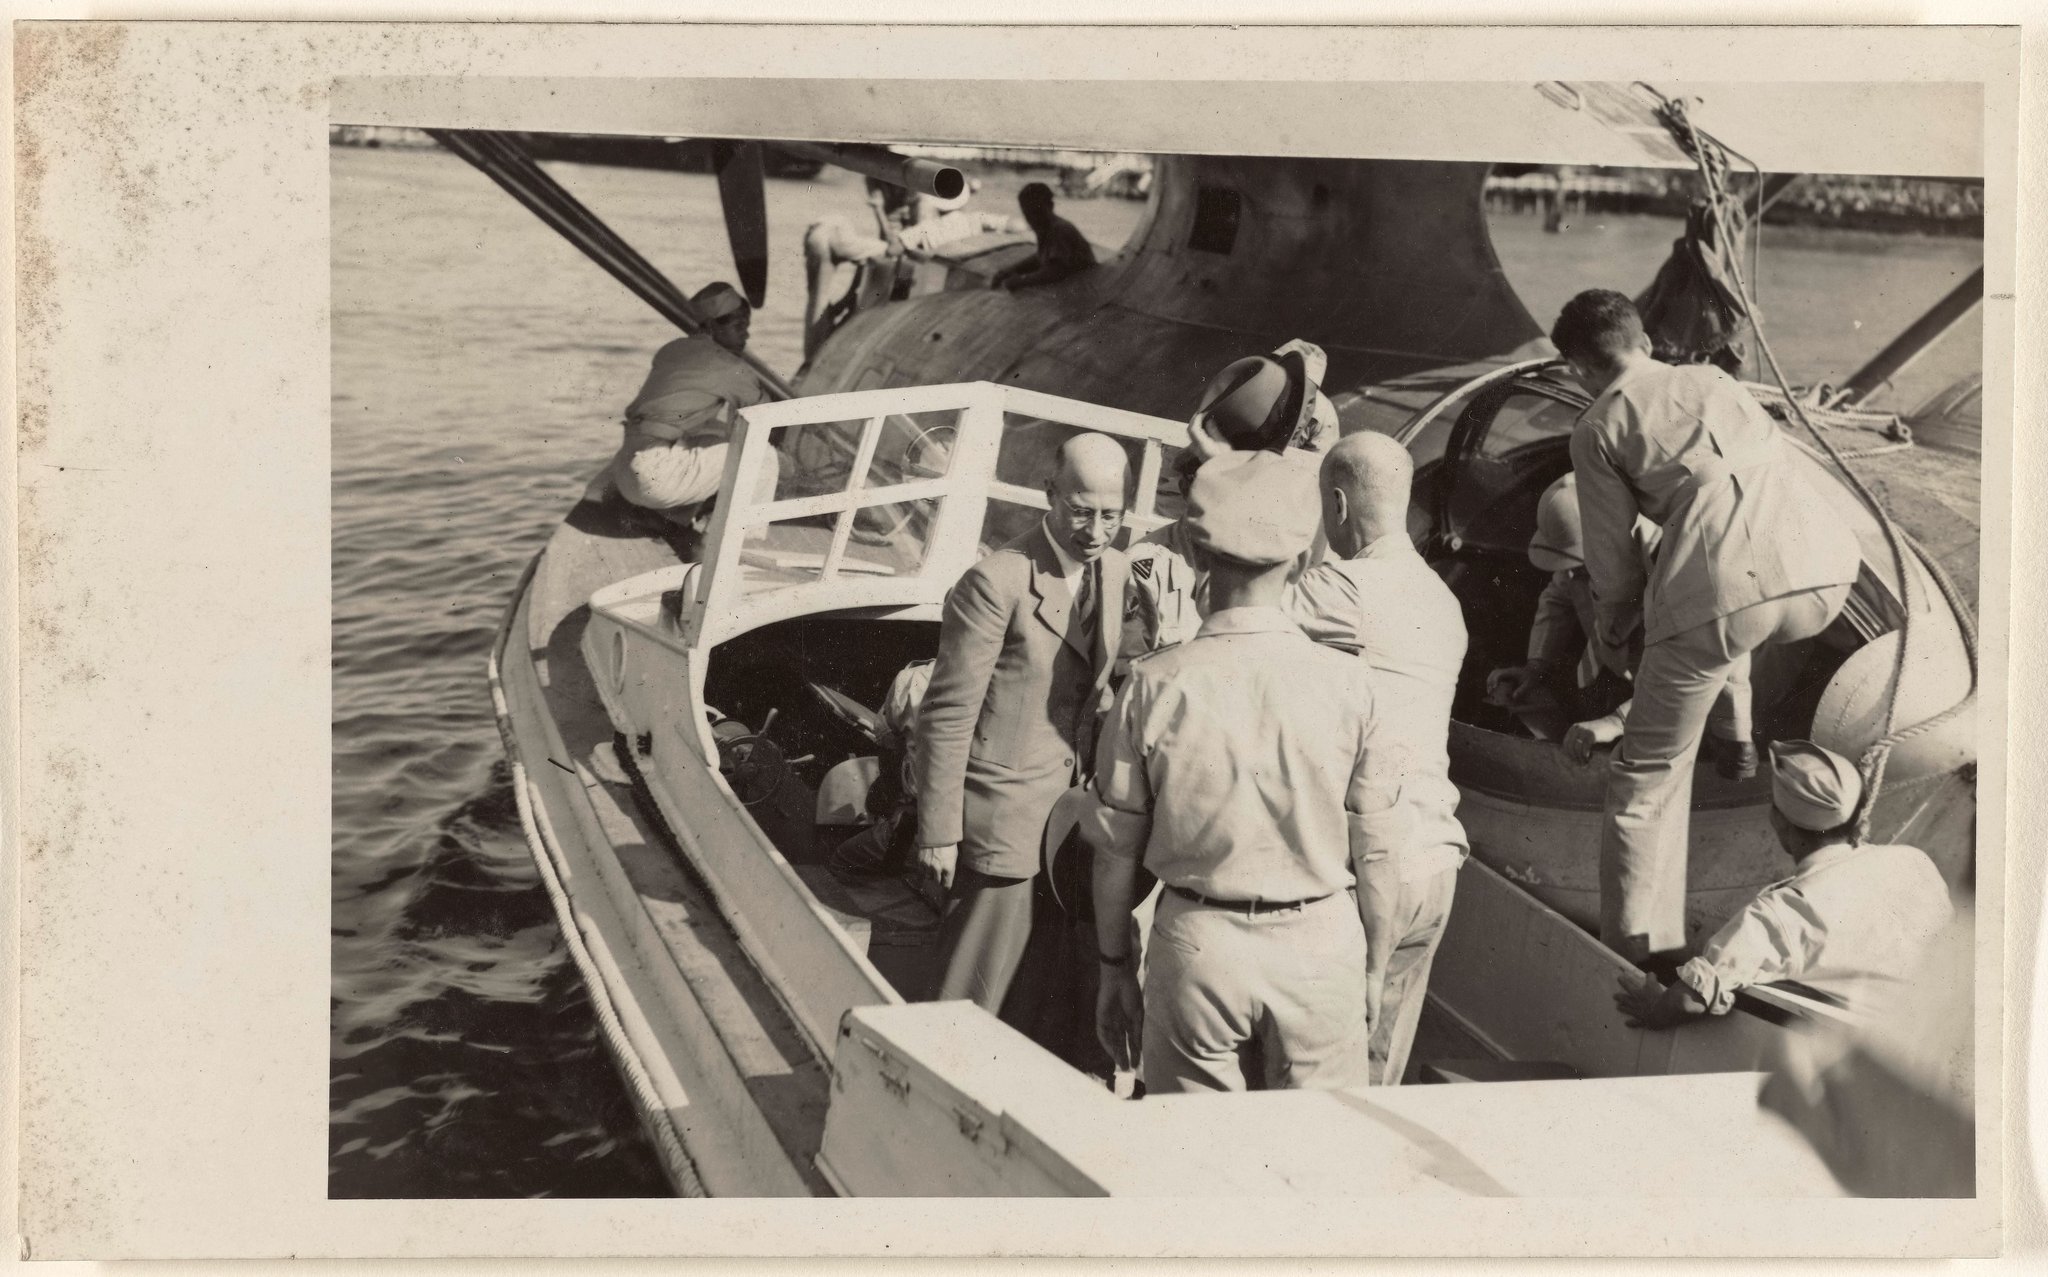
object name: documentary photograph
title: Minister-president Beel bezoekt Borneo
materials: photographic support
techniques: photography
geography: borneo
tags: utrecht, louis jozeph maria beel, borneo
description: Op 11 mei 1947 stappen minister-president Beel, commissaris-generaal voor Nederlands-Indië, Max van Poll en minister voor Overzeese gebiedsdelen Jan Jonkman over van het vliegschip naar een boot om de tocht naar Borneo te vervolgen.